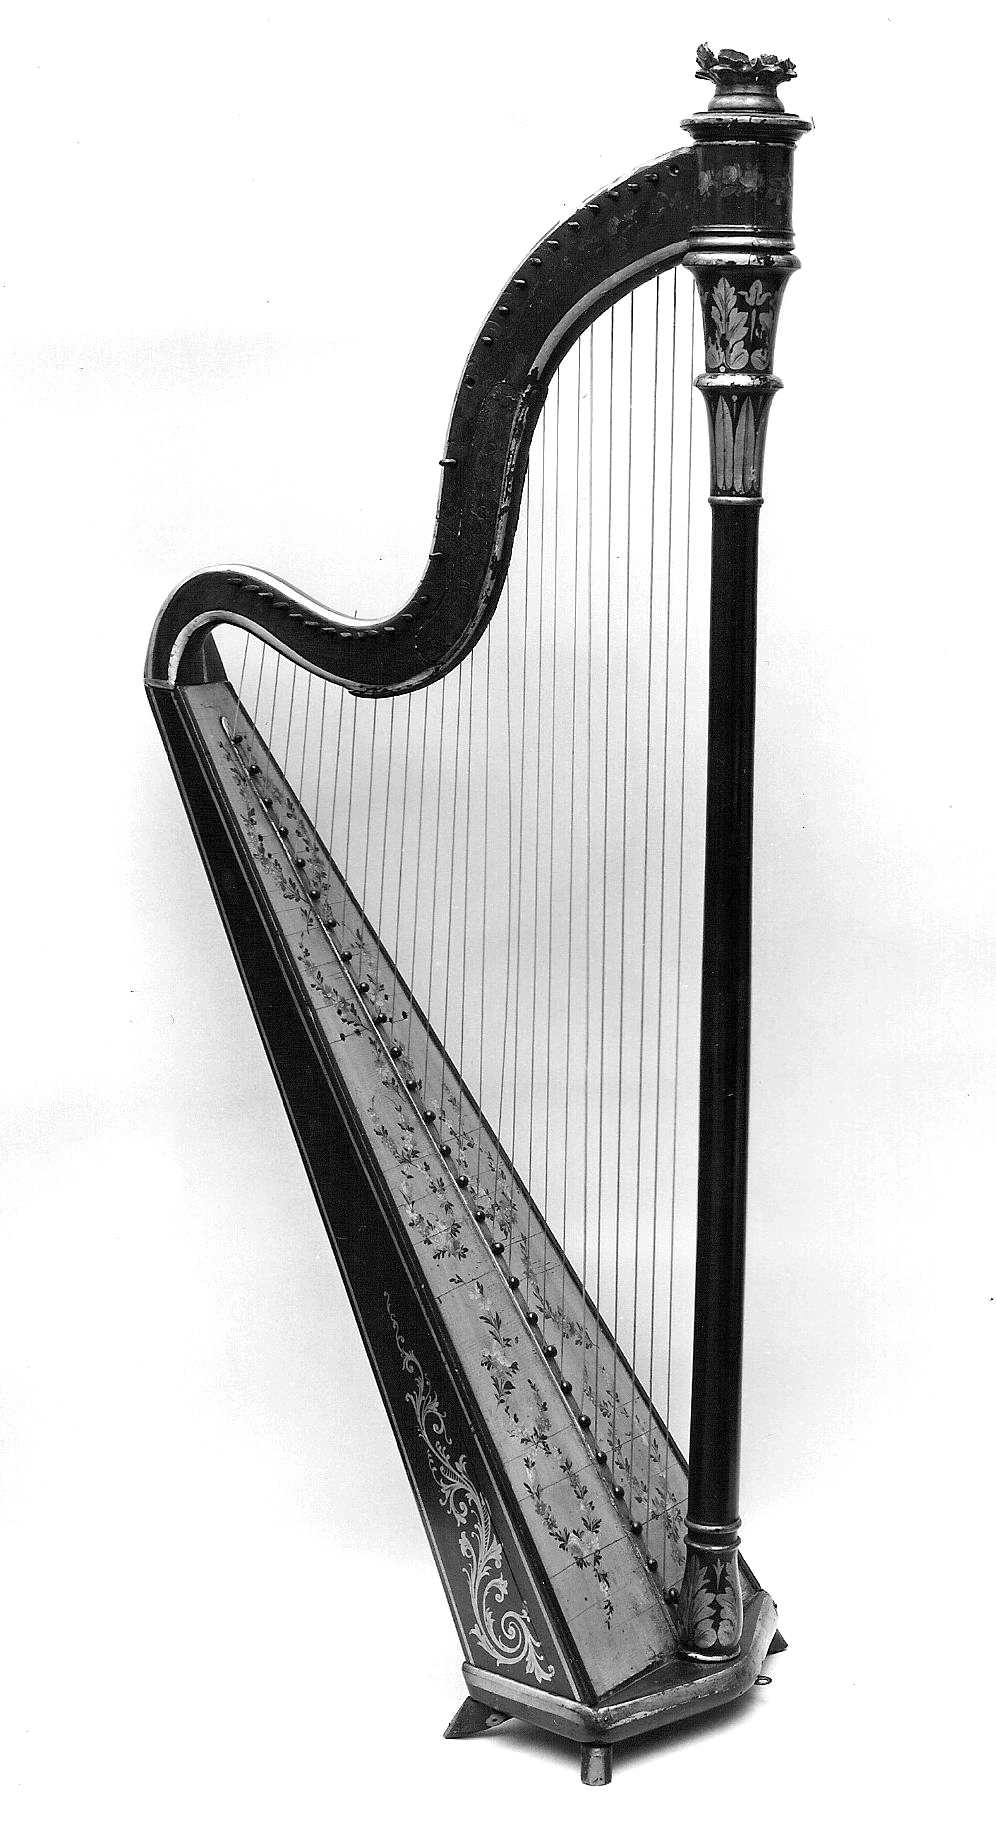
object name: portable harp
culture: european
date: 1734-1766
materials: wood